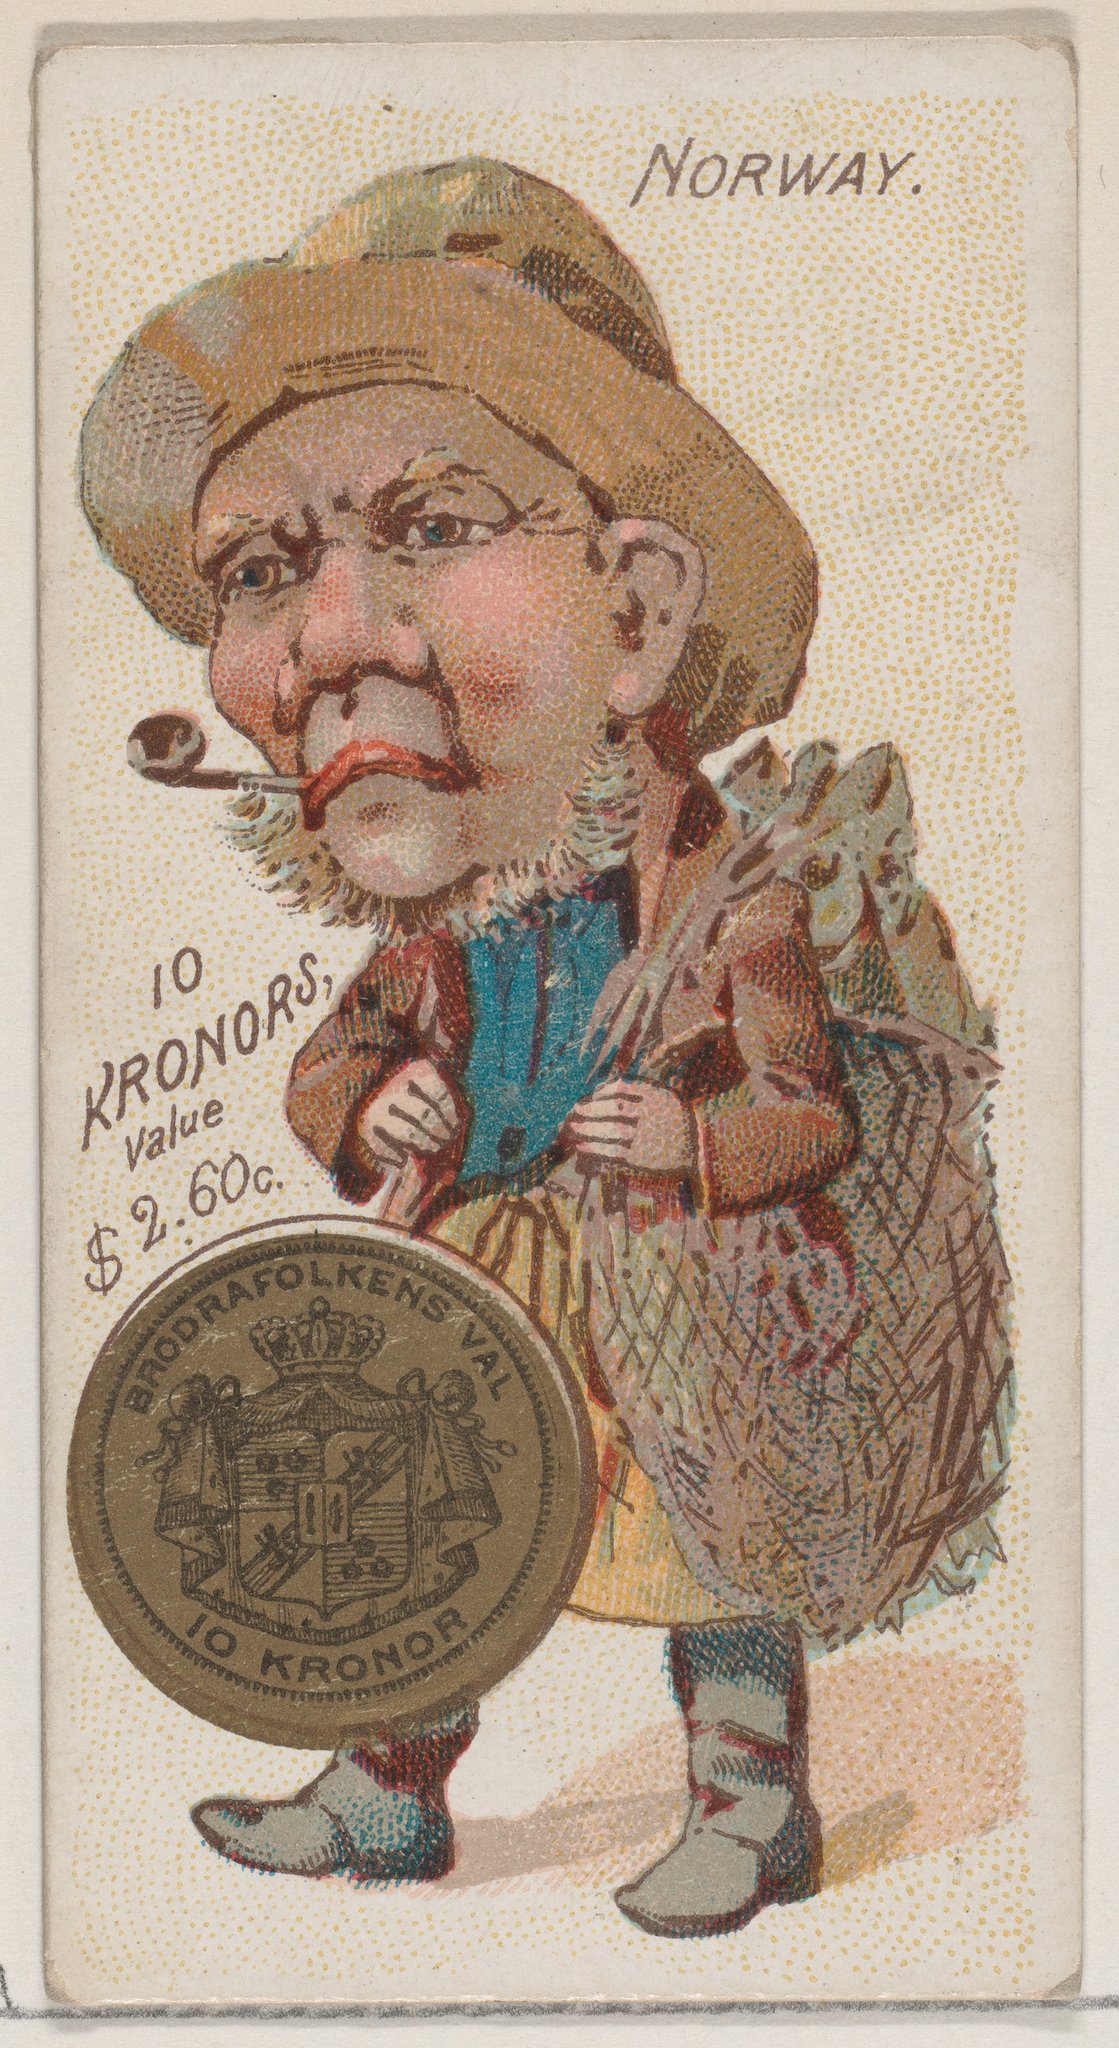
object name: print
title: Norway, 10 Kronors, from the series Coins of All Nations (N72, variation 1) for Duke brand cigarettes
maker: w. duke, sons & co.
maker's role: publisher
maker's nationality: american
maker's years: 1870-1920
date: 1889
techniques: color lithograph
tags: men,smoking,coins